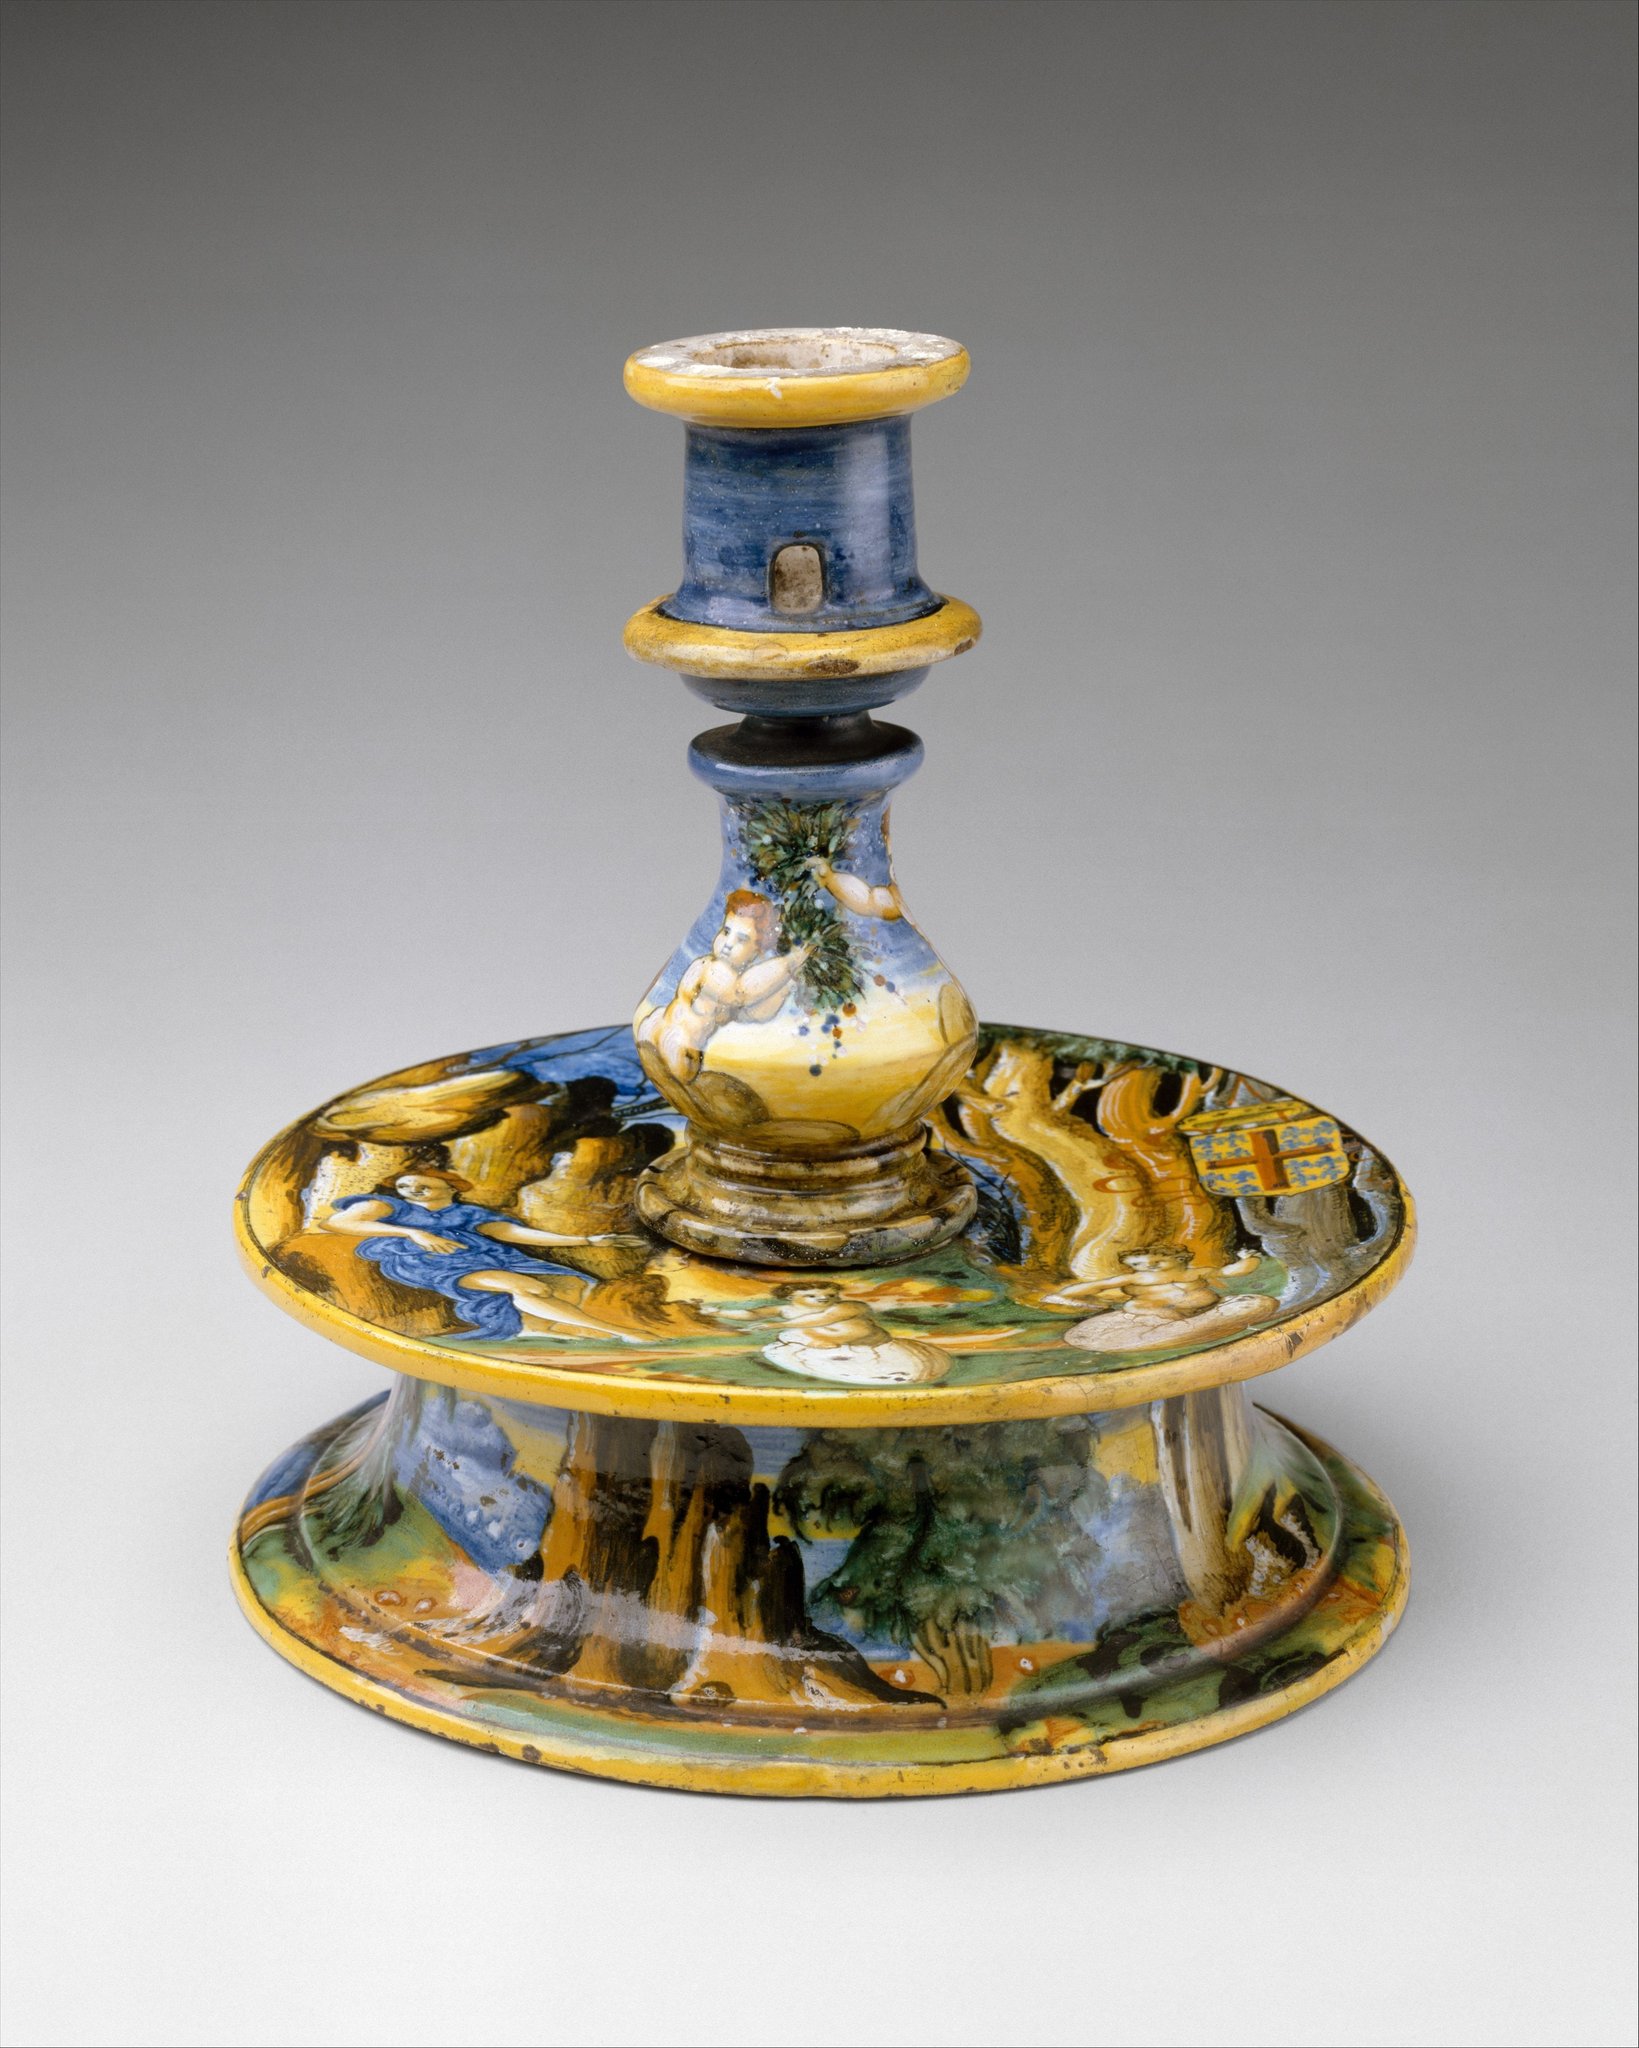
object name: candlestick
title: Candlestick (candeliere)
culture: italian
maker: workshop of guido durantino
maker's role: artist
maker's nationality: italian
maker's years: 1516-1581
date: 1535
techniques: maiolica, glazing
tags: women,leda